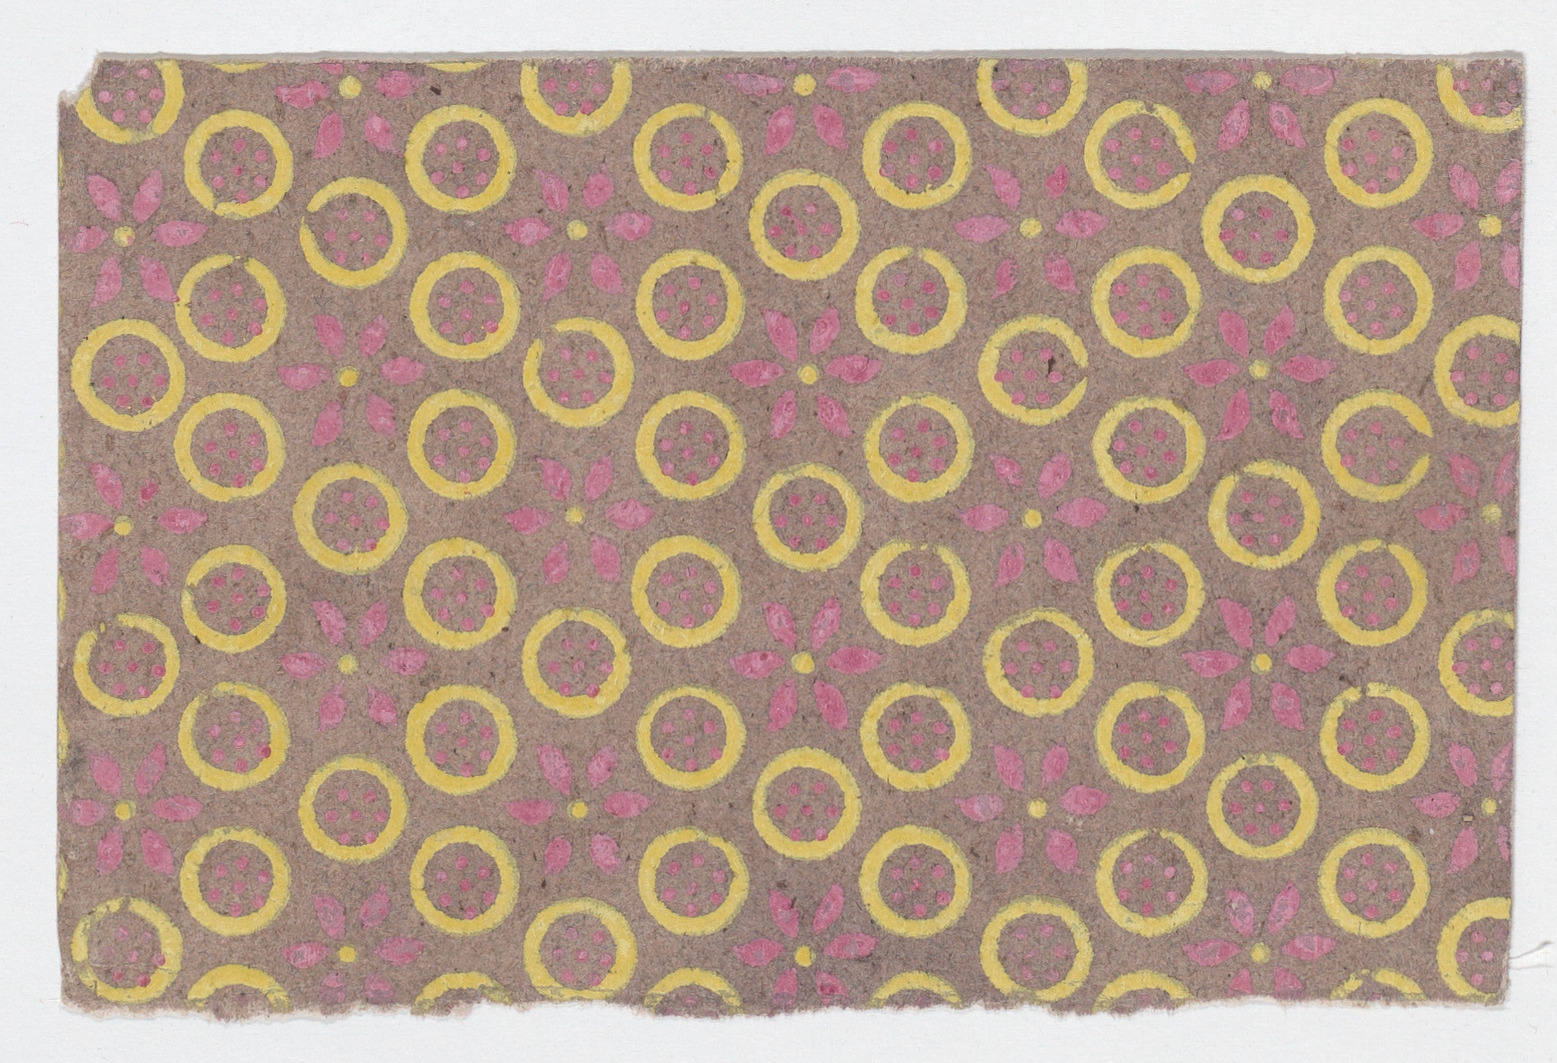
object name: print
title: Sheet with pattern of flowers and circles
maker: Anonymous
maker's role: artist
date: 1801-1900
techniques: relief print